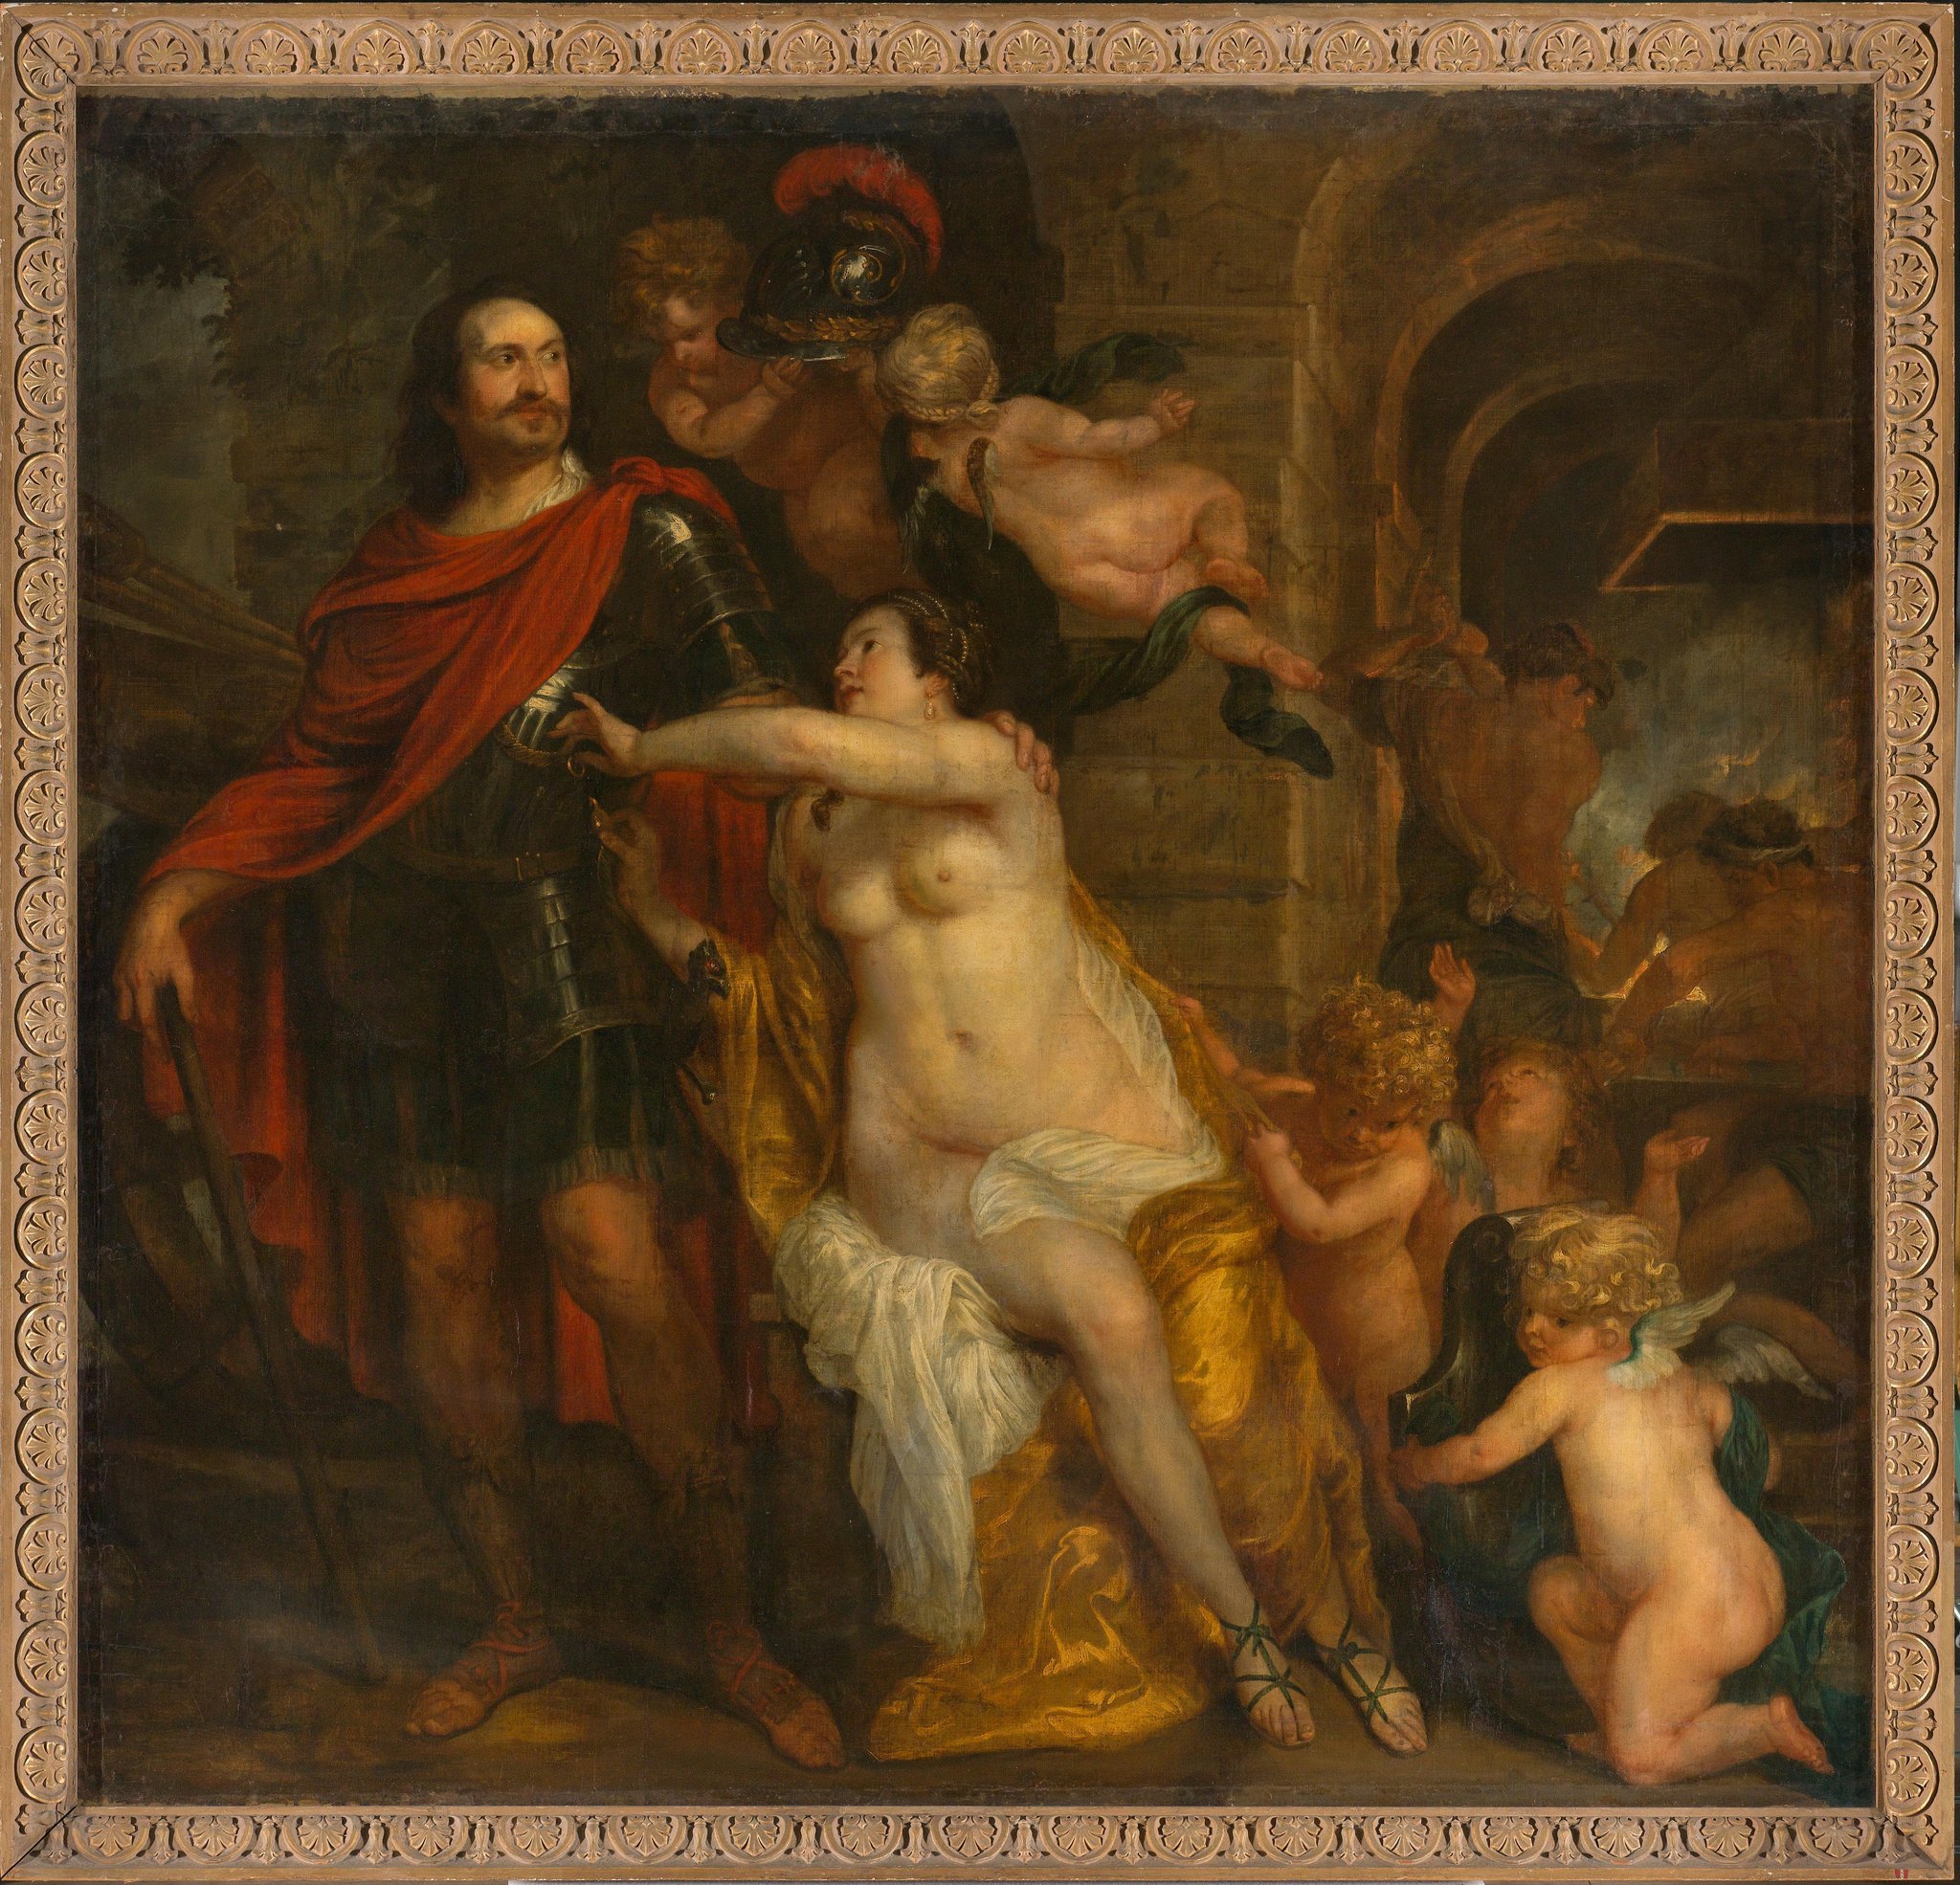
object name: painting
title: Venus Arming a Warrior, possibly Johan Maurits at the Forge of Vulcan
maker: thomas willeboirts bosschaert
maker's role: draughtsman, painter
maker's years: 1613-1654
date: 1644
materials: canvas, oil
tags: berlin, frederik willem van brandenburg (i), the hague, louise henriëtte (prinses van oranje), venus hands over the armour to aeneas, historical persons - bb - woman, historical persons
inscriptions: inscription, bottom right: ‘TW[ILL]’, signature, bottom right: ‘T. Willeboirch’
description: Mars wordt door Venus het zwaard aangegespt, twee putti tillen de helm naar zijn hoofd. Rechtsonder meer putti met andere delen van de wapenrusting, op de achtergrond is Vulcanus in zijn werkplaats aan het smeden. Historische allegorie met waarschijnlijk Friedrich Wilhelm, keurvorst van Brandenburg, als Mars en Louisa Henrietta, gravin van Nassau, als Venus.